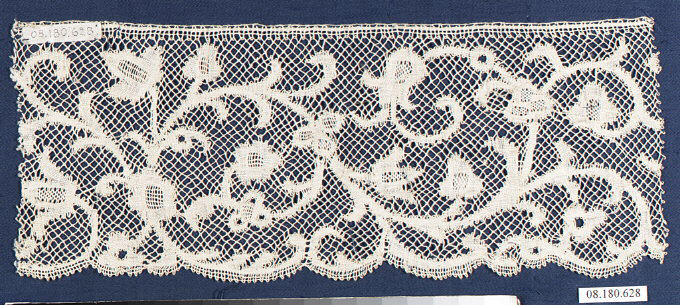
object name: piece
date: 1801-1900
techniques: lace